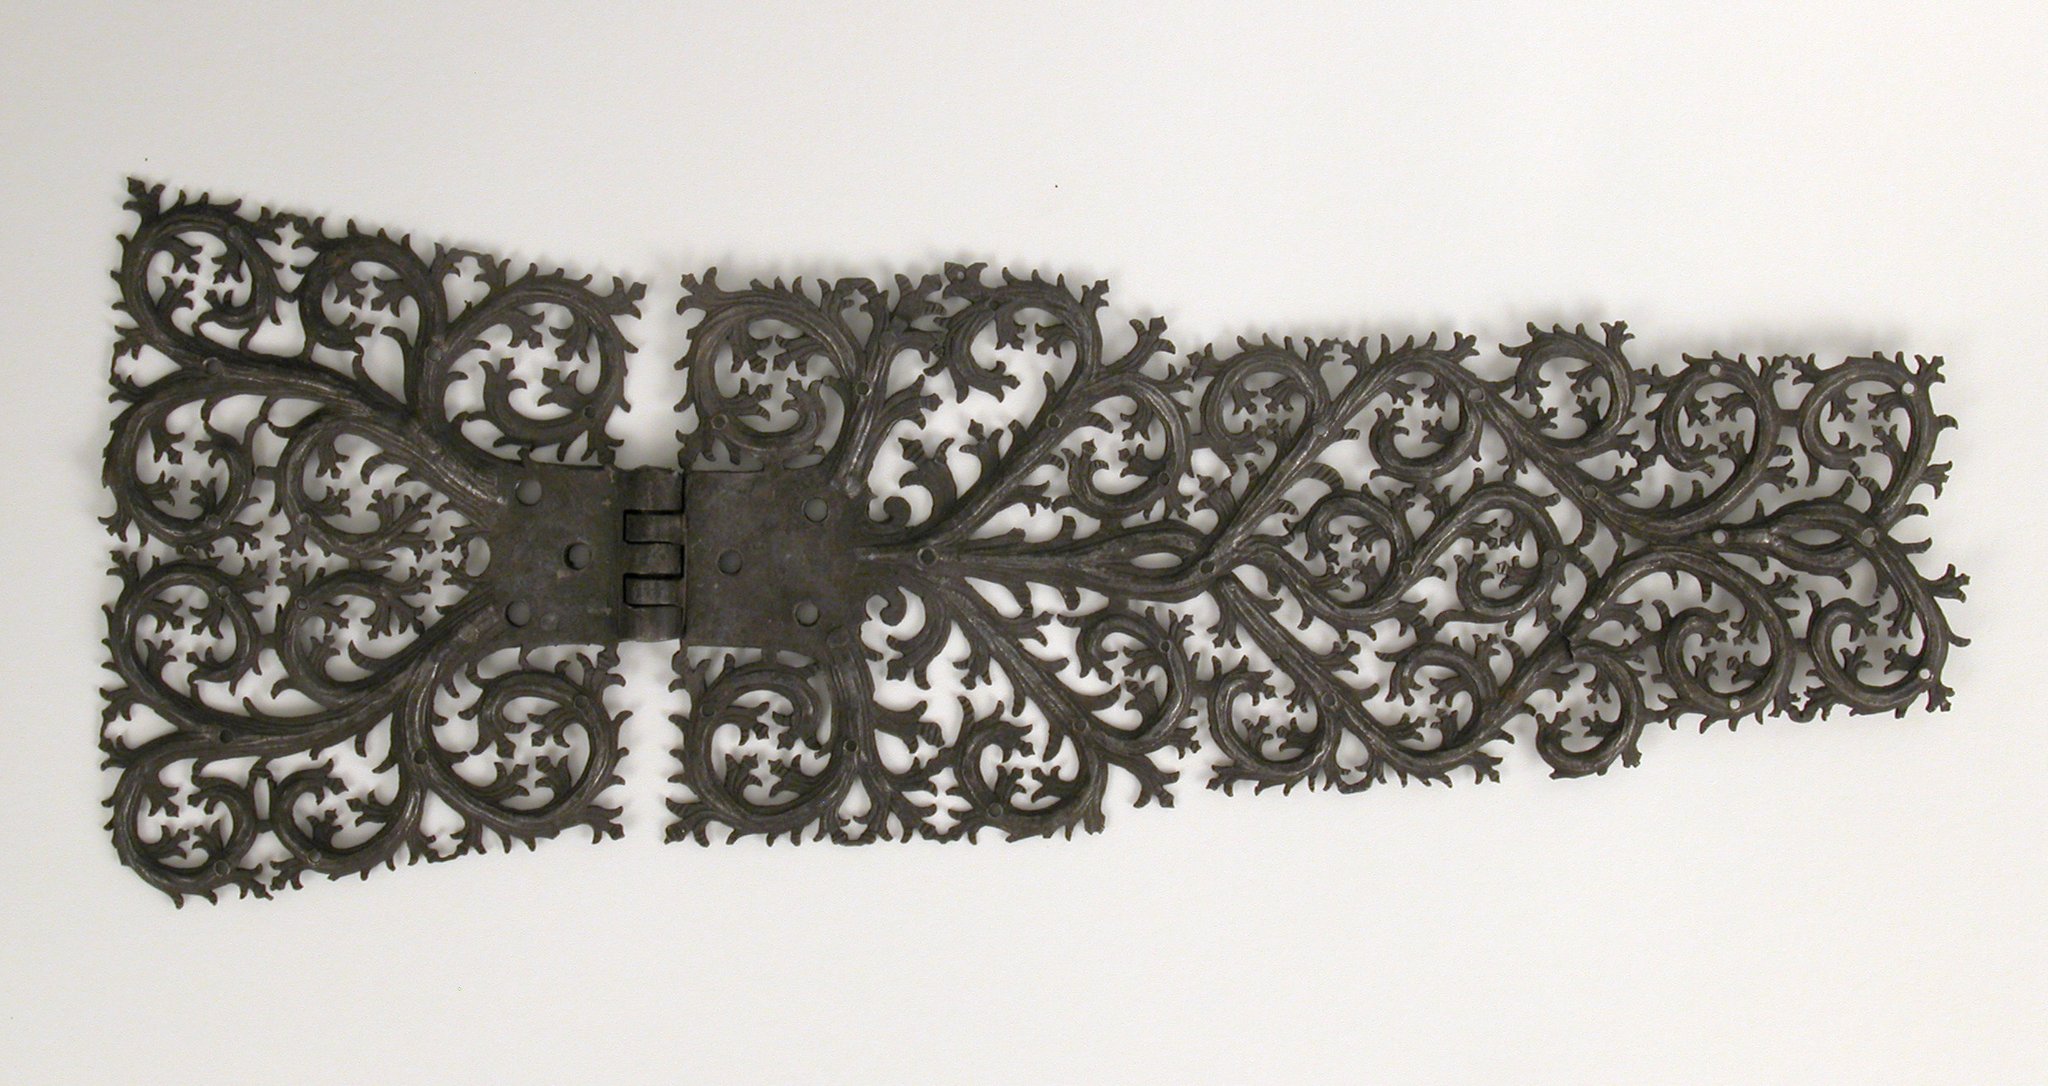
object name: hinge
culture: german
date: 1401-1500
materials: iron